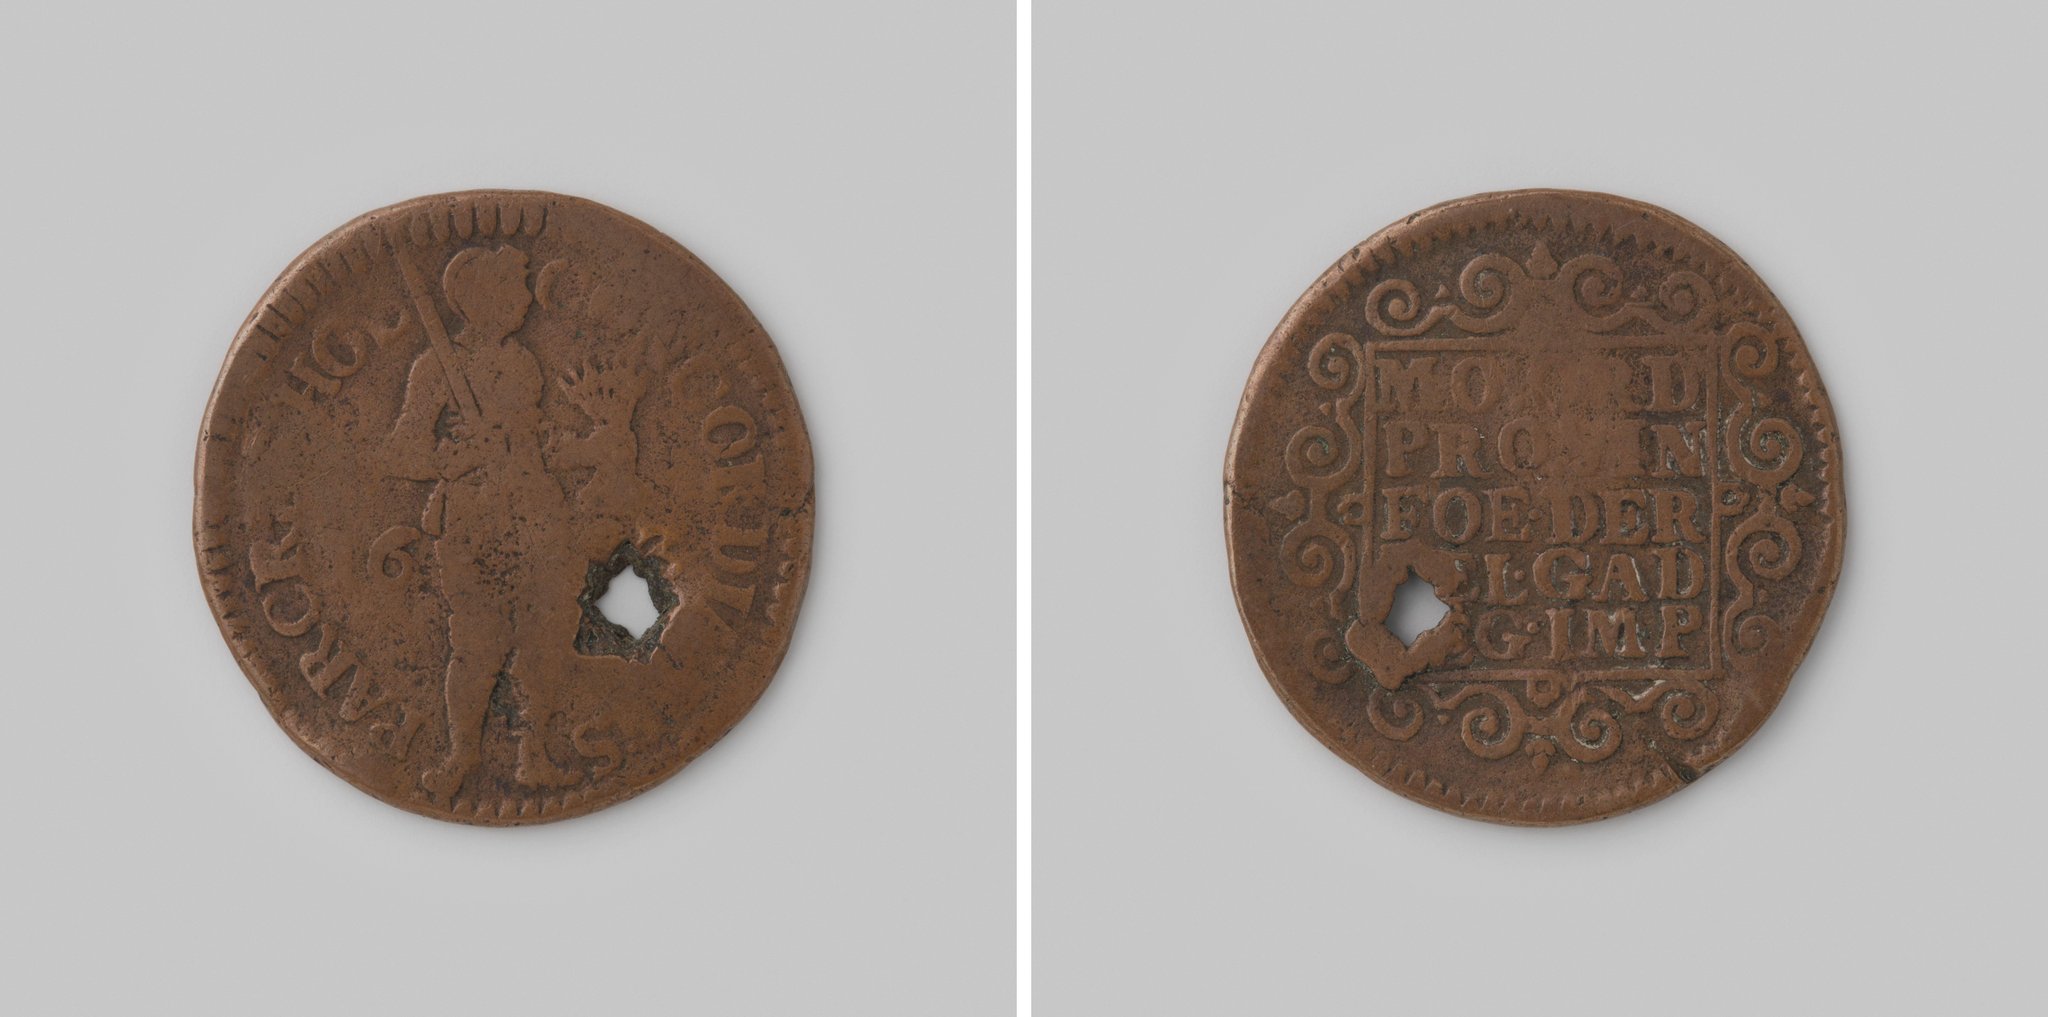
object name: coin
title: Holland, dukaat, 1673. Proef in koper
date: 1673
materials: copper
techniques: striking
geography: dordrecht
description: Koperen munt. Voorzijde: tussen jaartal staande ridder naar rechts. In rechterhand zwaard, in linkerhand pijlenbundel. Keerzijde: in versierd vierkant vijfregelig opschrift. Kabelrand